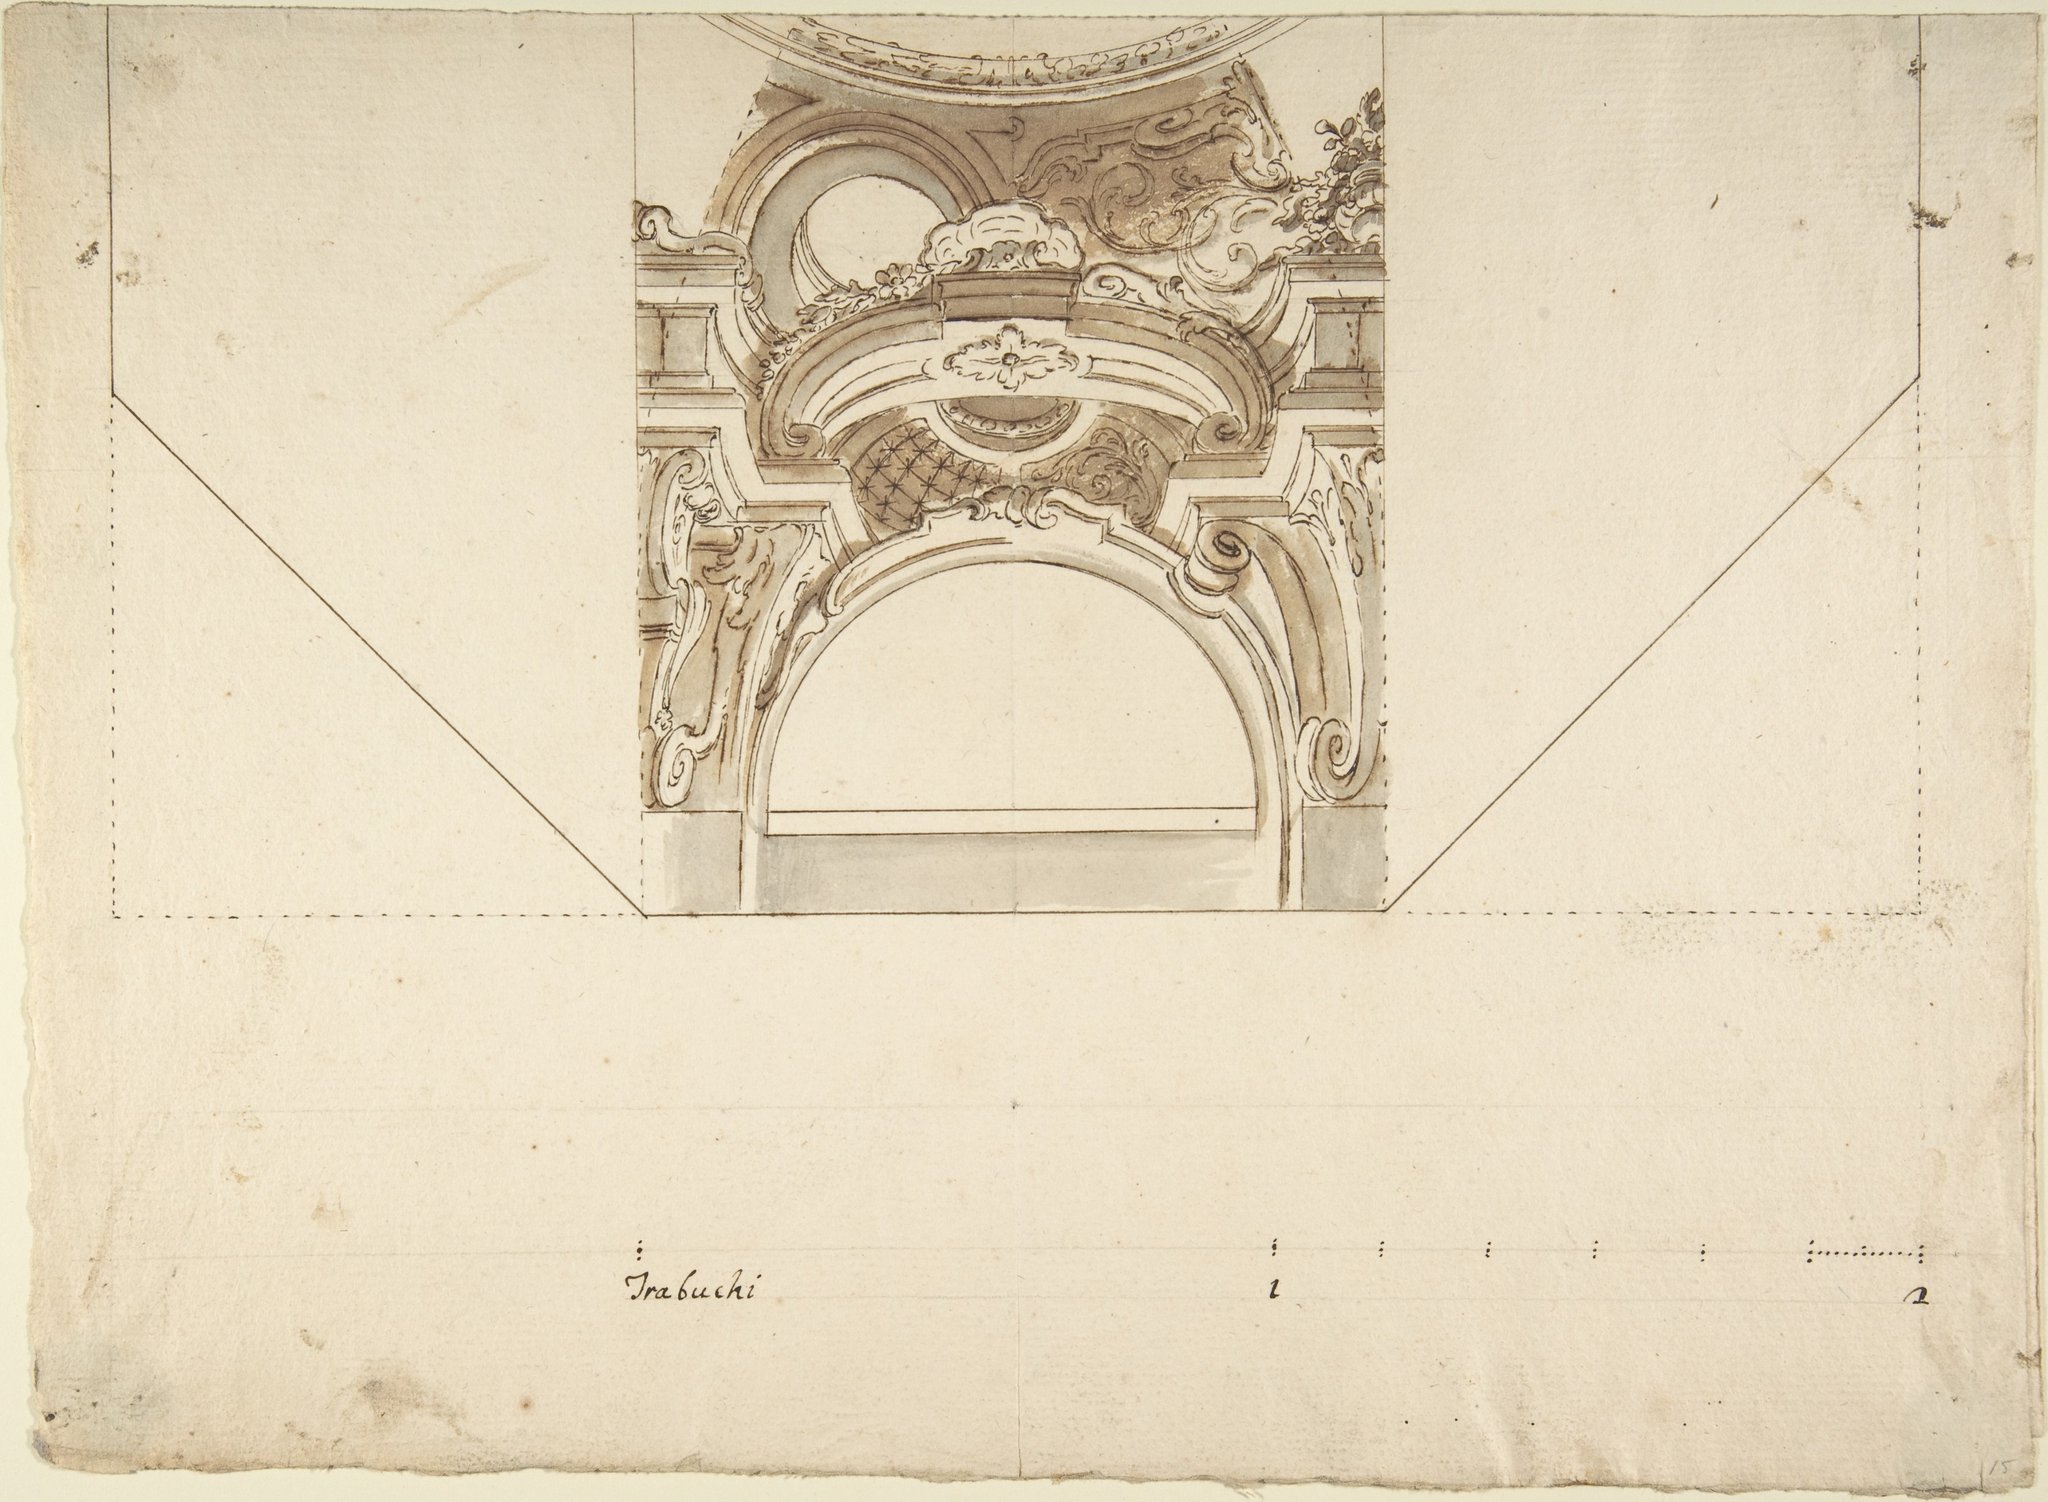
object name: drawing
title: Two alternate projects for a Cornice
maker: anonymous, italian, piedmontese, 18th century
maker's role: artist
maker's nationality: italian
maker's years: 1700-1800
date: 1700-1780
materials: ink, lead, drawing material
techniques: brush, pen, wash